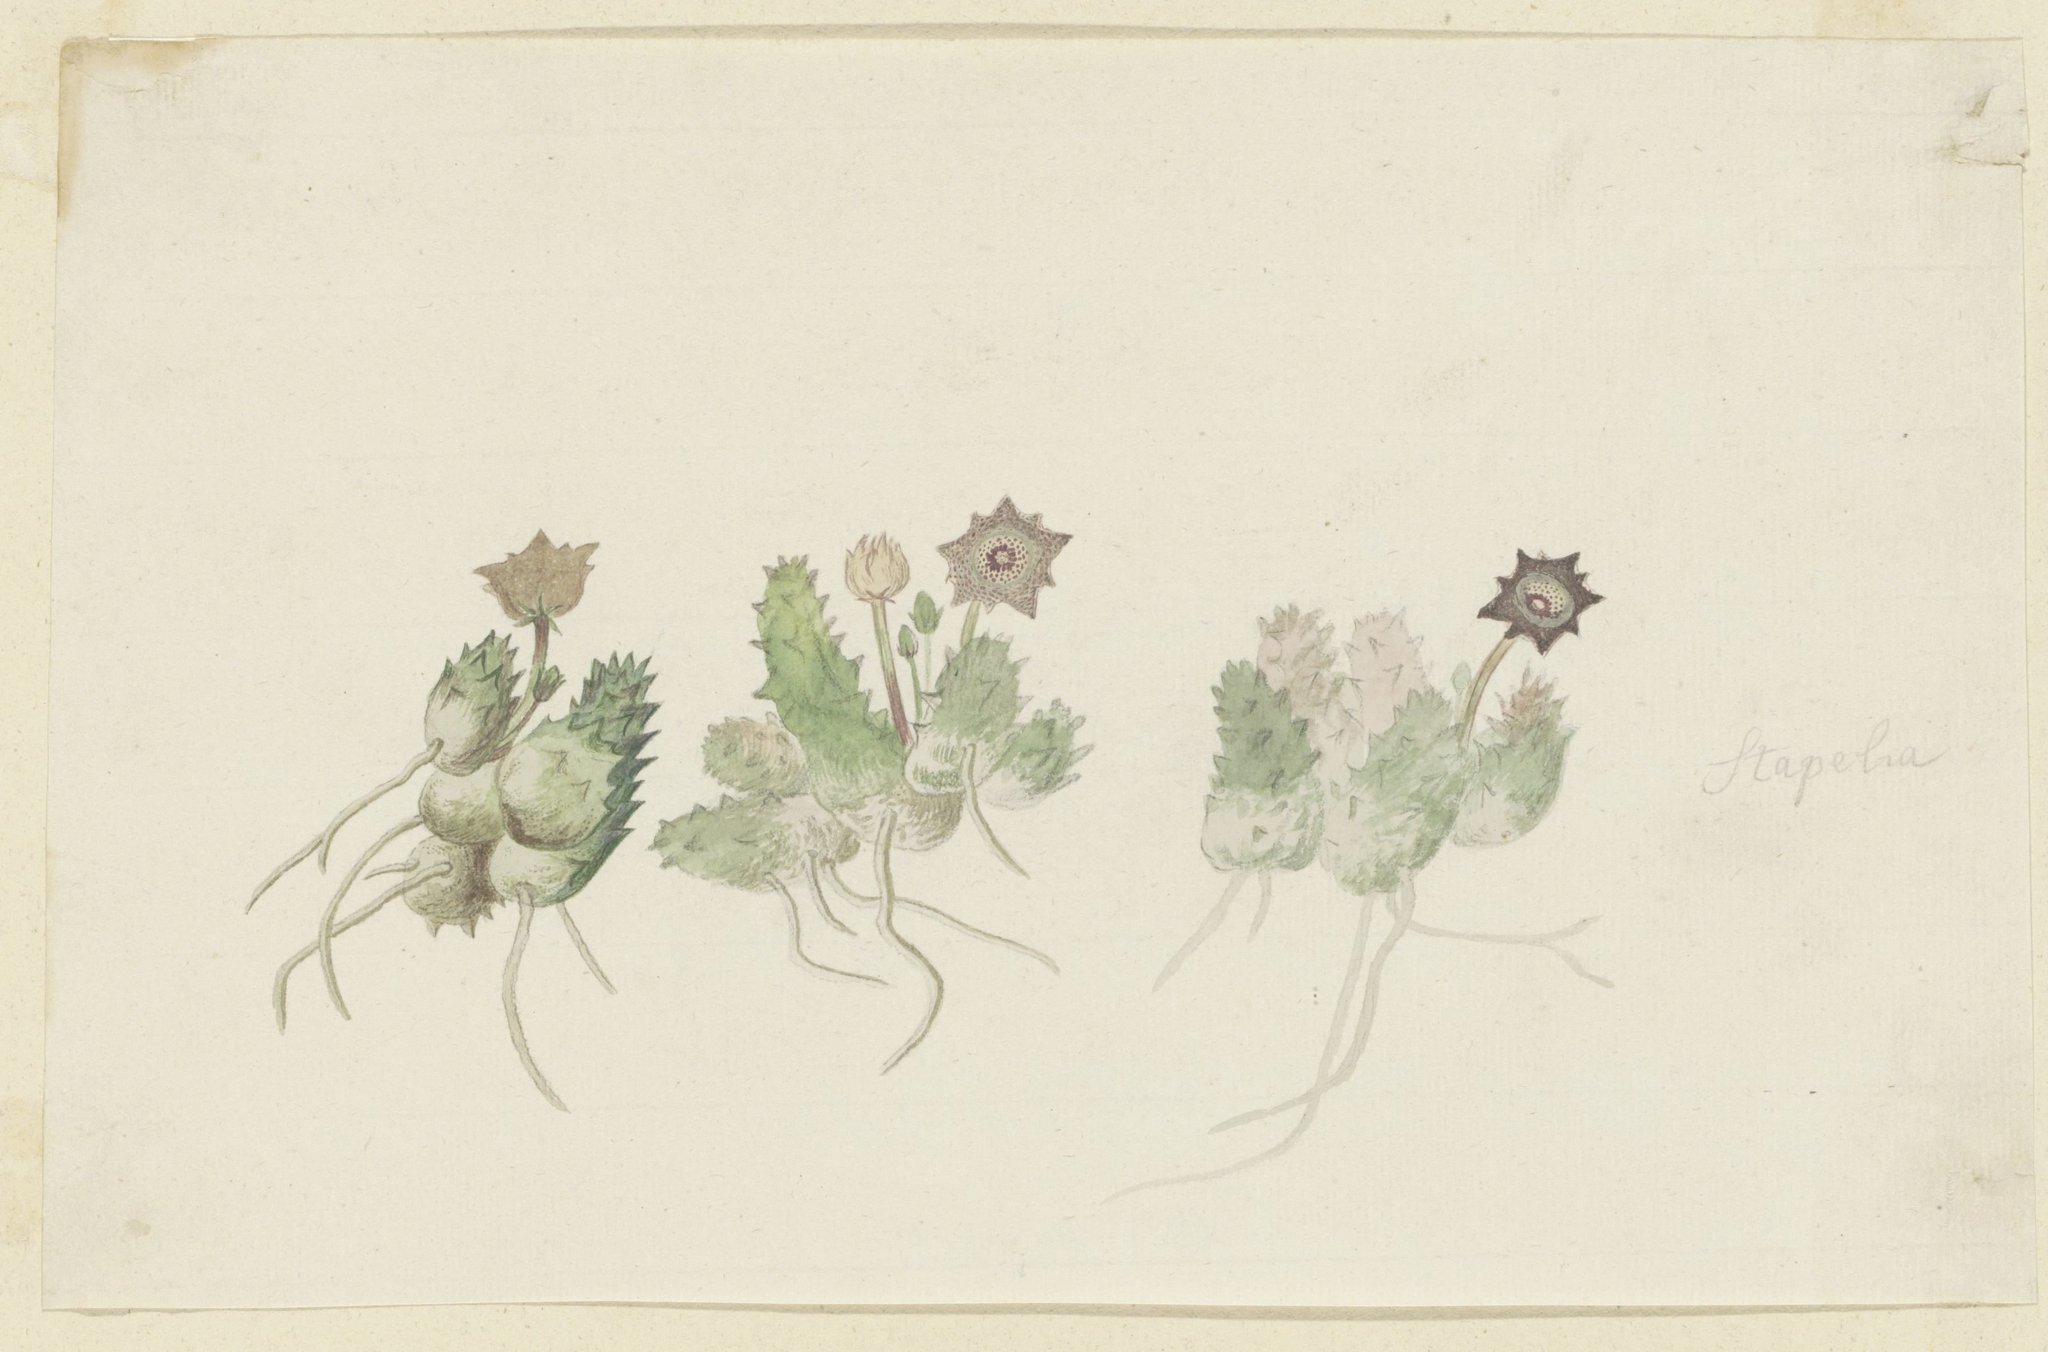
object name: drawing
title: Orbea verrucosa (Masson) L.C. Leach. (Hirsute Stapelia)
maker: robert jacob gordon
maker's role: draughtsman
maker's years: 1743-1795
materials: chalk, paper, pencil, watercolor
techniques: brush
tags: plants; vegetation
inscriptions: annotation: ‘Stapelia.’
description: De tekening is gemaakt voor of tijdens een van Gordon's vier expedities door de Kaapprovincie, van oktober 1777 tot maart 1786. Sommige (soort)namen kunnen zijn gewijzigd, gezien reorganisatie in plantentaxonomie gedurende de afgelopen jaren.